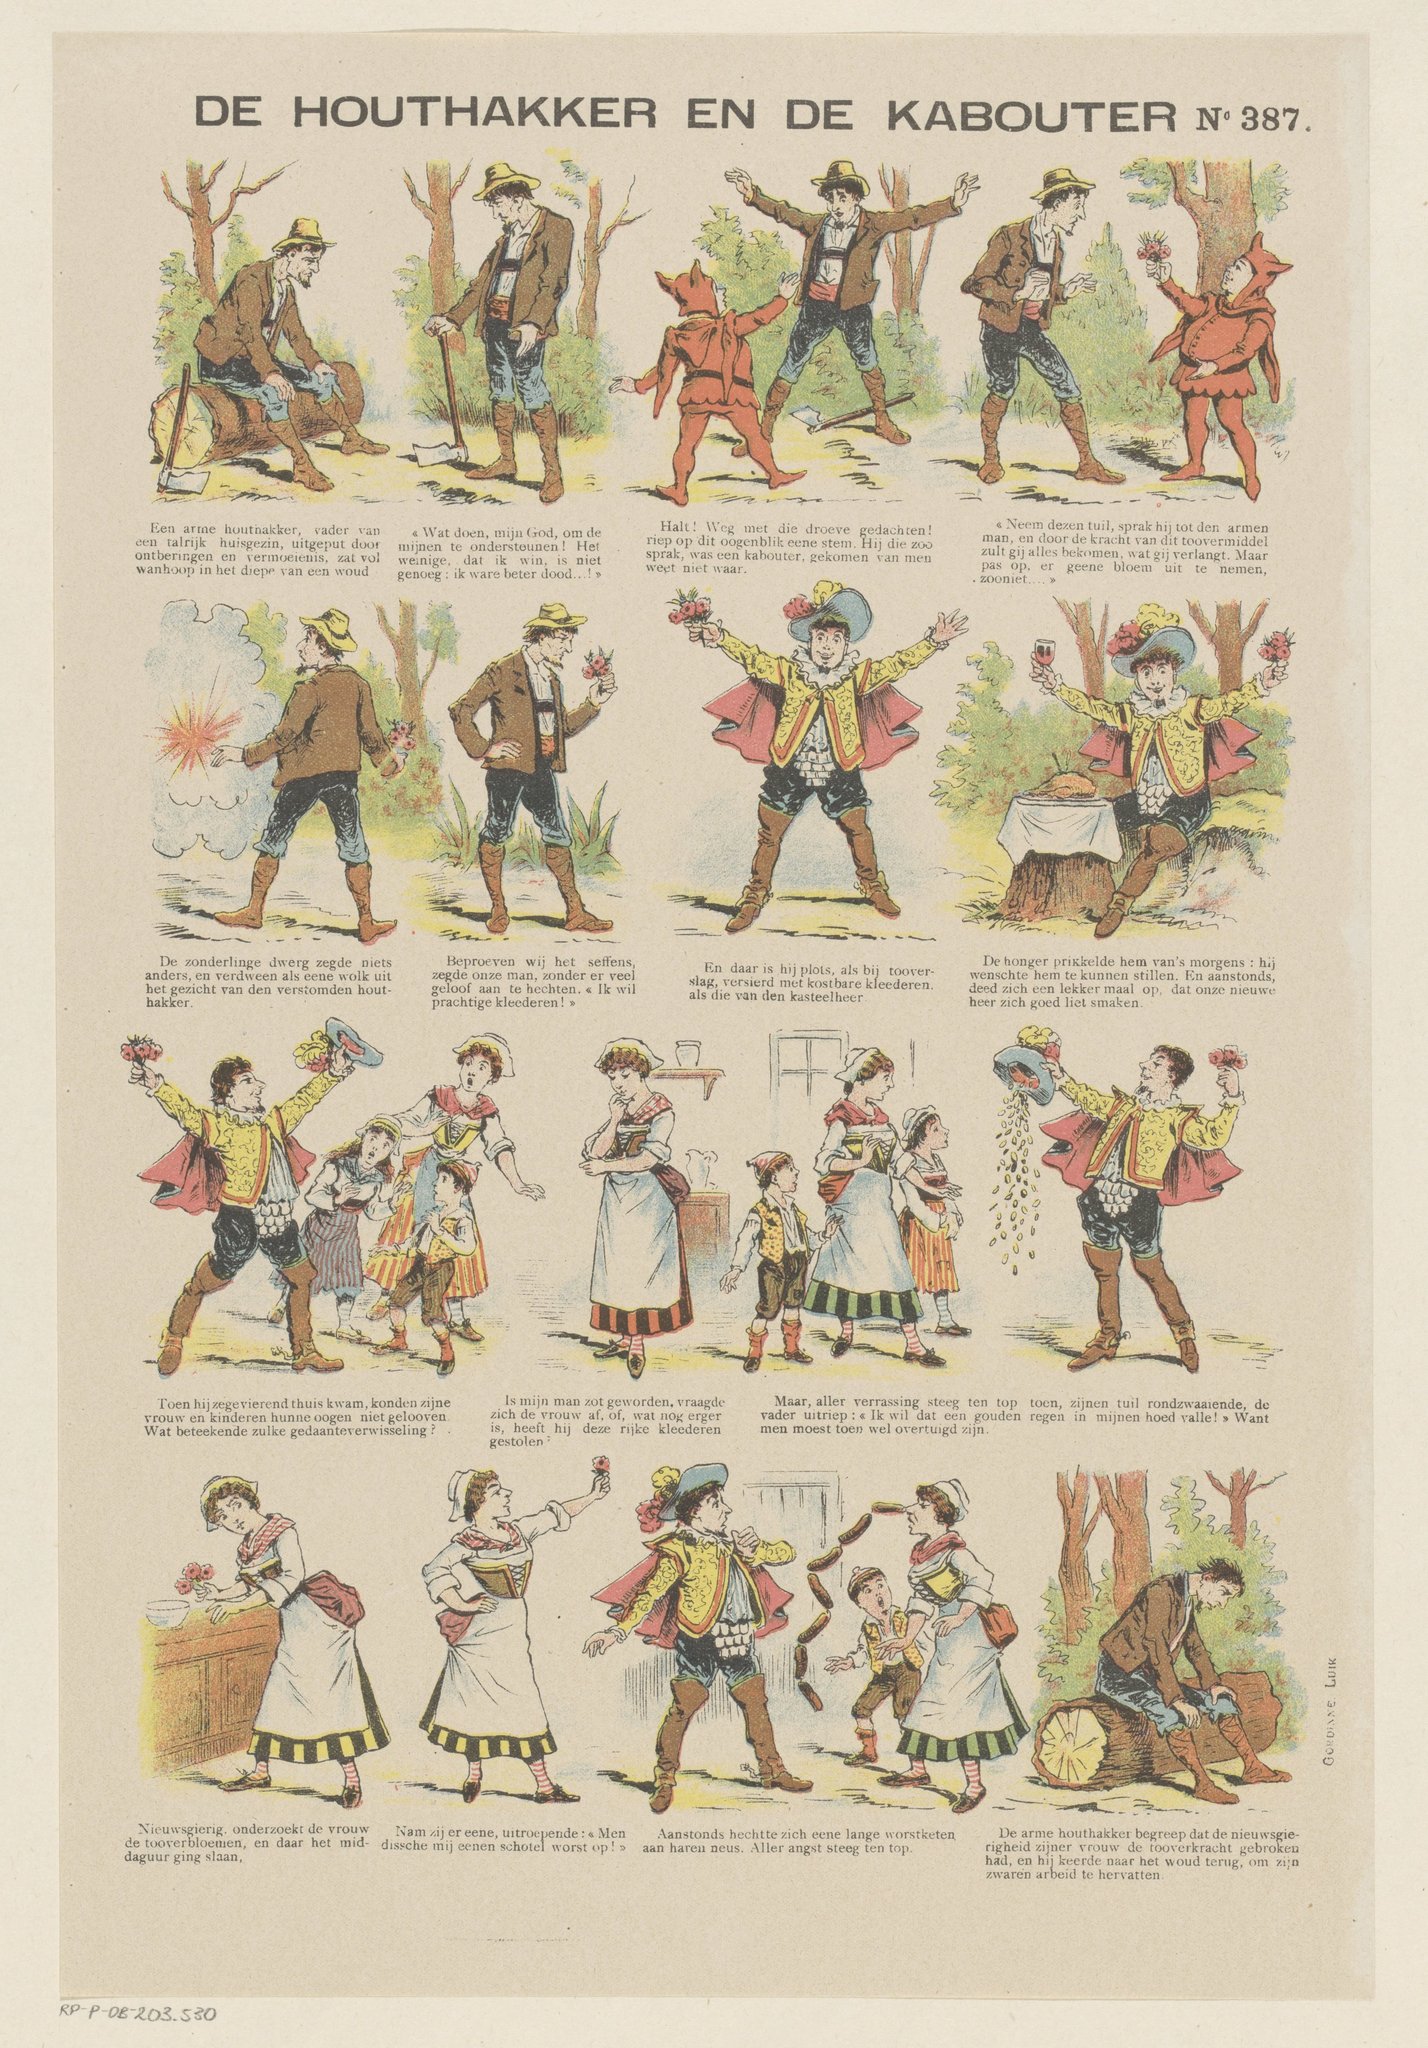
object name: print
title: De houthakker en de kabouter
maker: Anonymous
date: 1894-1959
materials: paper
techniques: lithograph, letterpress printing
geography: liège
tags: magic, supernaturalism, occultism, woodcutting, woodcutter ~ forestry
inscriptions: collector's mark: Lugt 2760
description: Blad met 15 voorstellingen over een houthakker die van een kabouter toverbloemen ontvangt. Alles wat hij maar wenst laten de bloemen tevoorschijn komen. De nieuwsgierigheid van zijn vrouw verbreekt echter de betovering. Onder elke afbeelding een onderschrift. Genummerd rechtsboven: No 387.